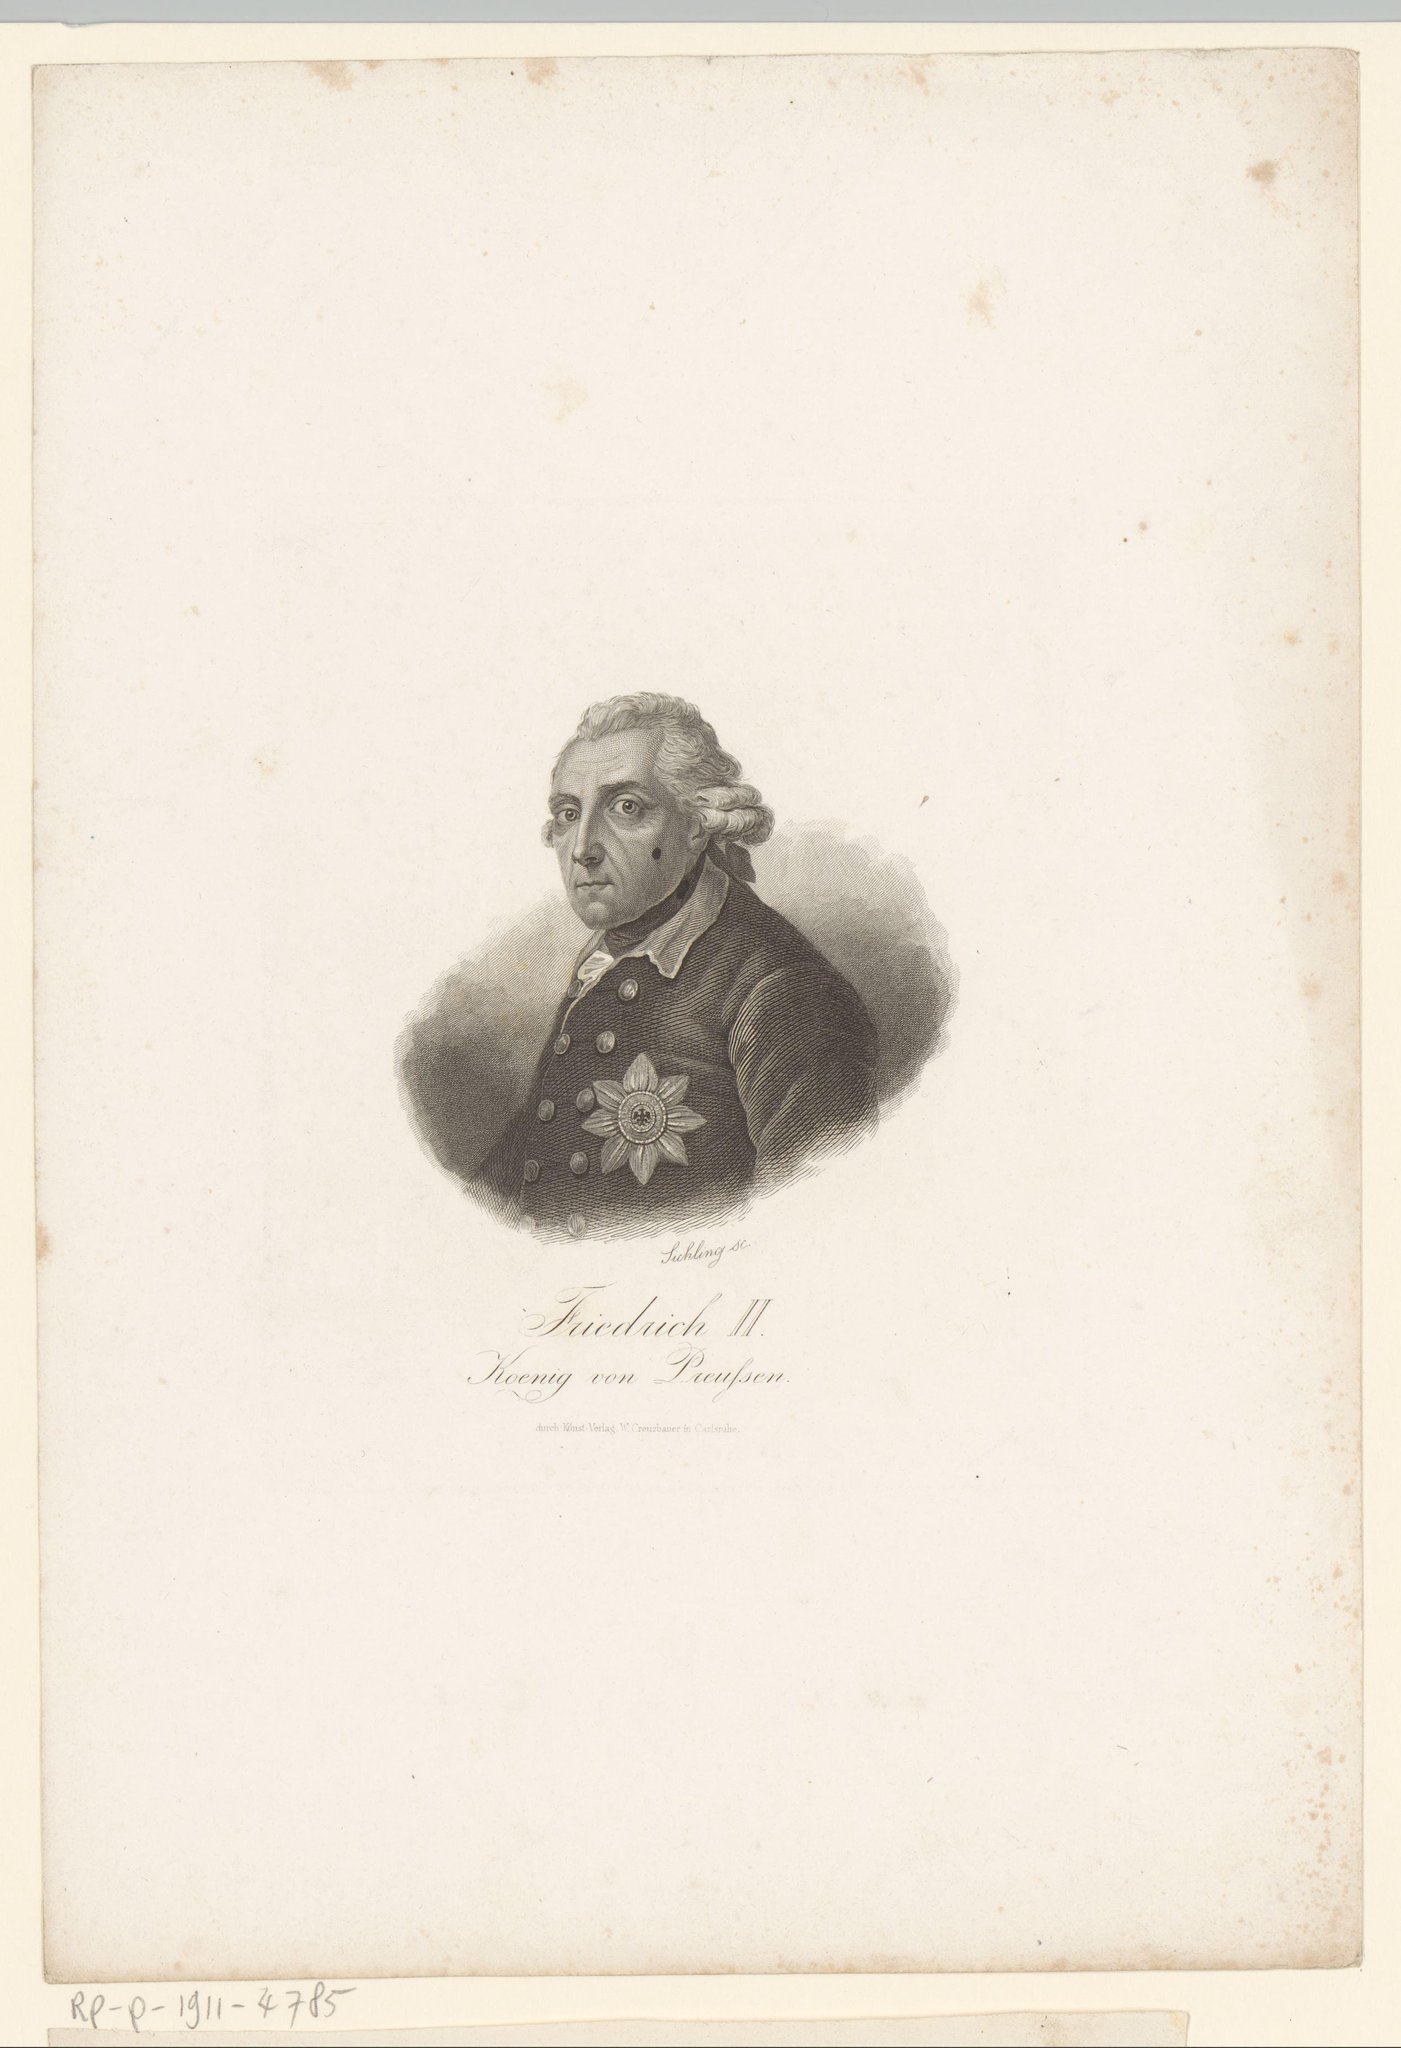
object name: print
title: Portret van Frederik de Grote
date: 1822-1863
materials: paper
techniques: aquarelle, engraving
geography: karlsruhe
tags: berlin, frederick ii (king of prussia), knighthood order (with name) - insignia of a knighthood order, e.g.: badge, chain (with name of order), historical persons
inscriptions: collector's mark: Lugt 2228